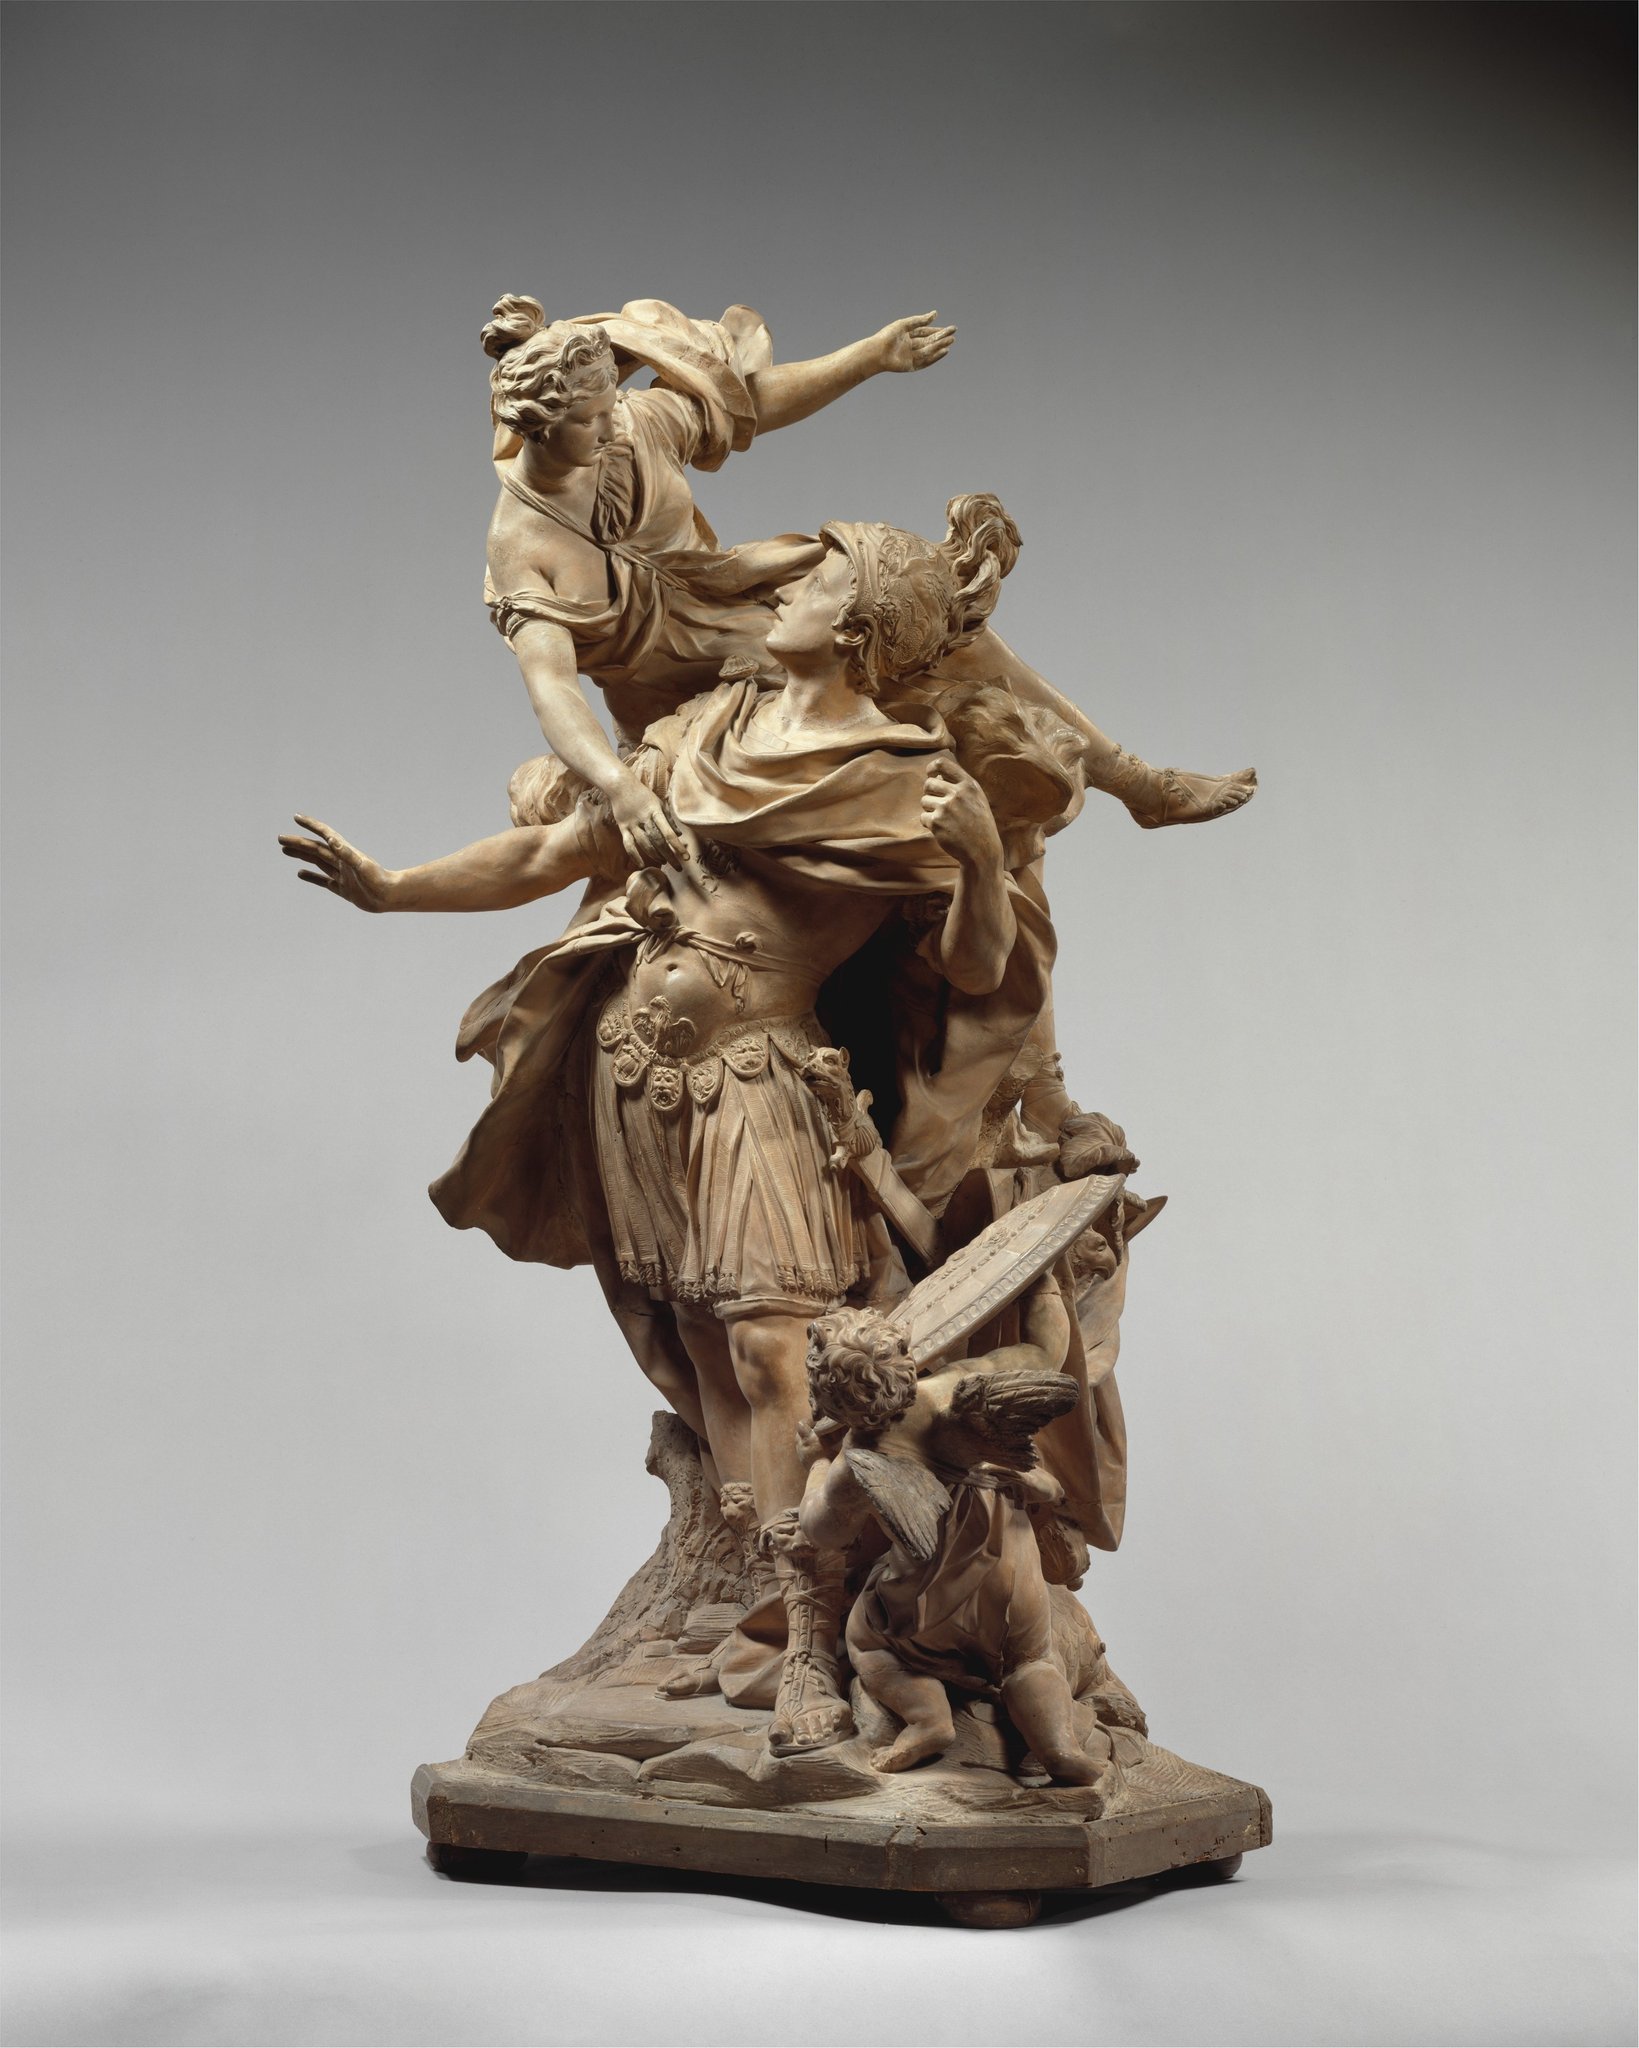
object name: group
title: Venus Giving Arms to Aeneas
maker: jean cornu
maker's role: artist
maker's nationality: french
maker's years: 1650-1710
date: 1704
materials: terracotta, wood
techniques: painting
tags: men,women,cupid,aeneas,venus,aeneid